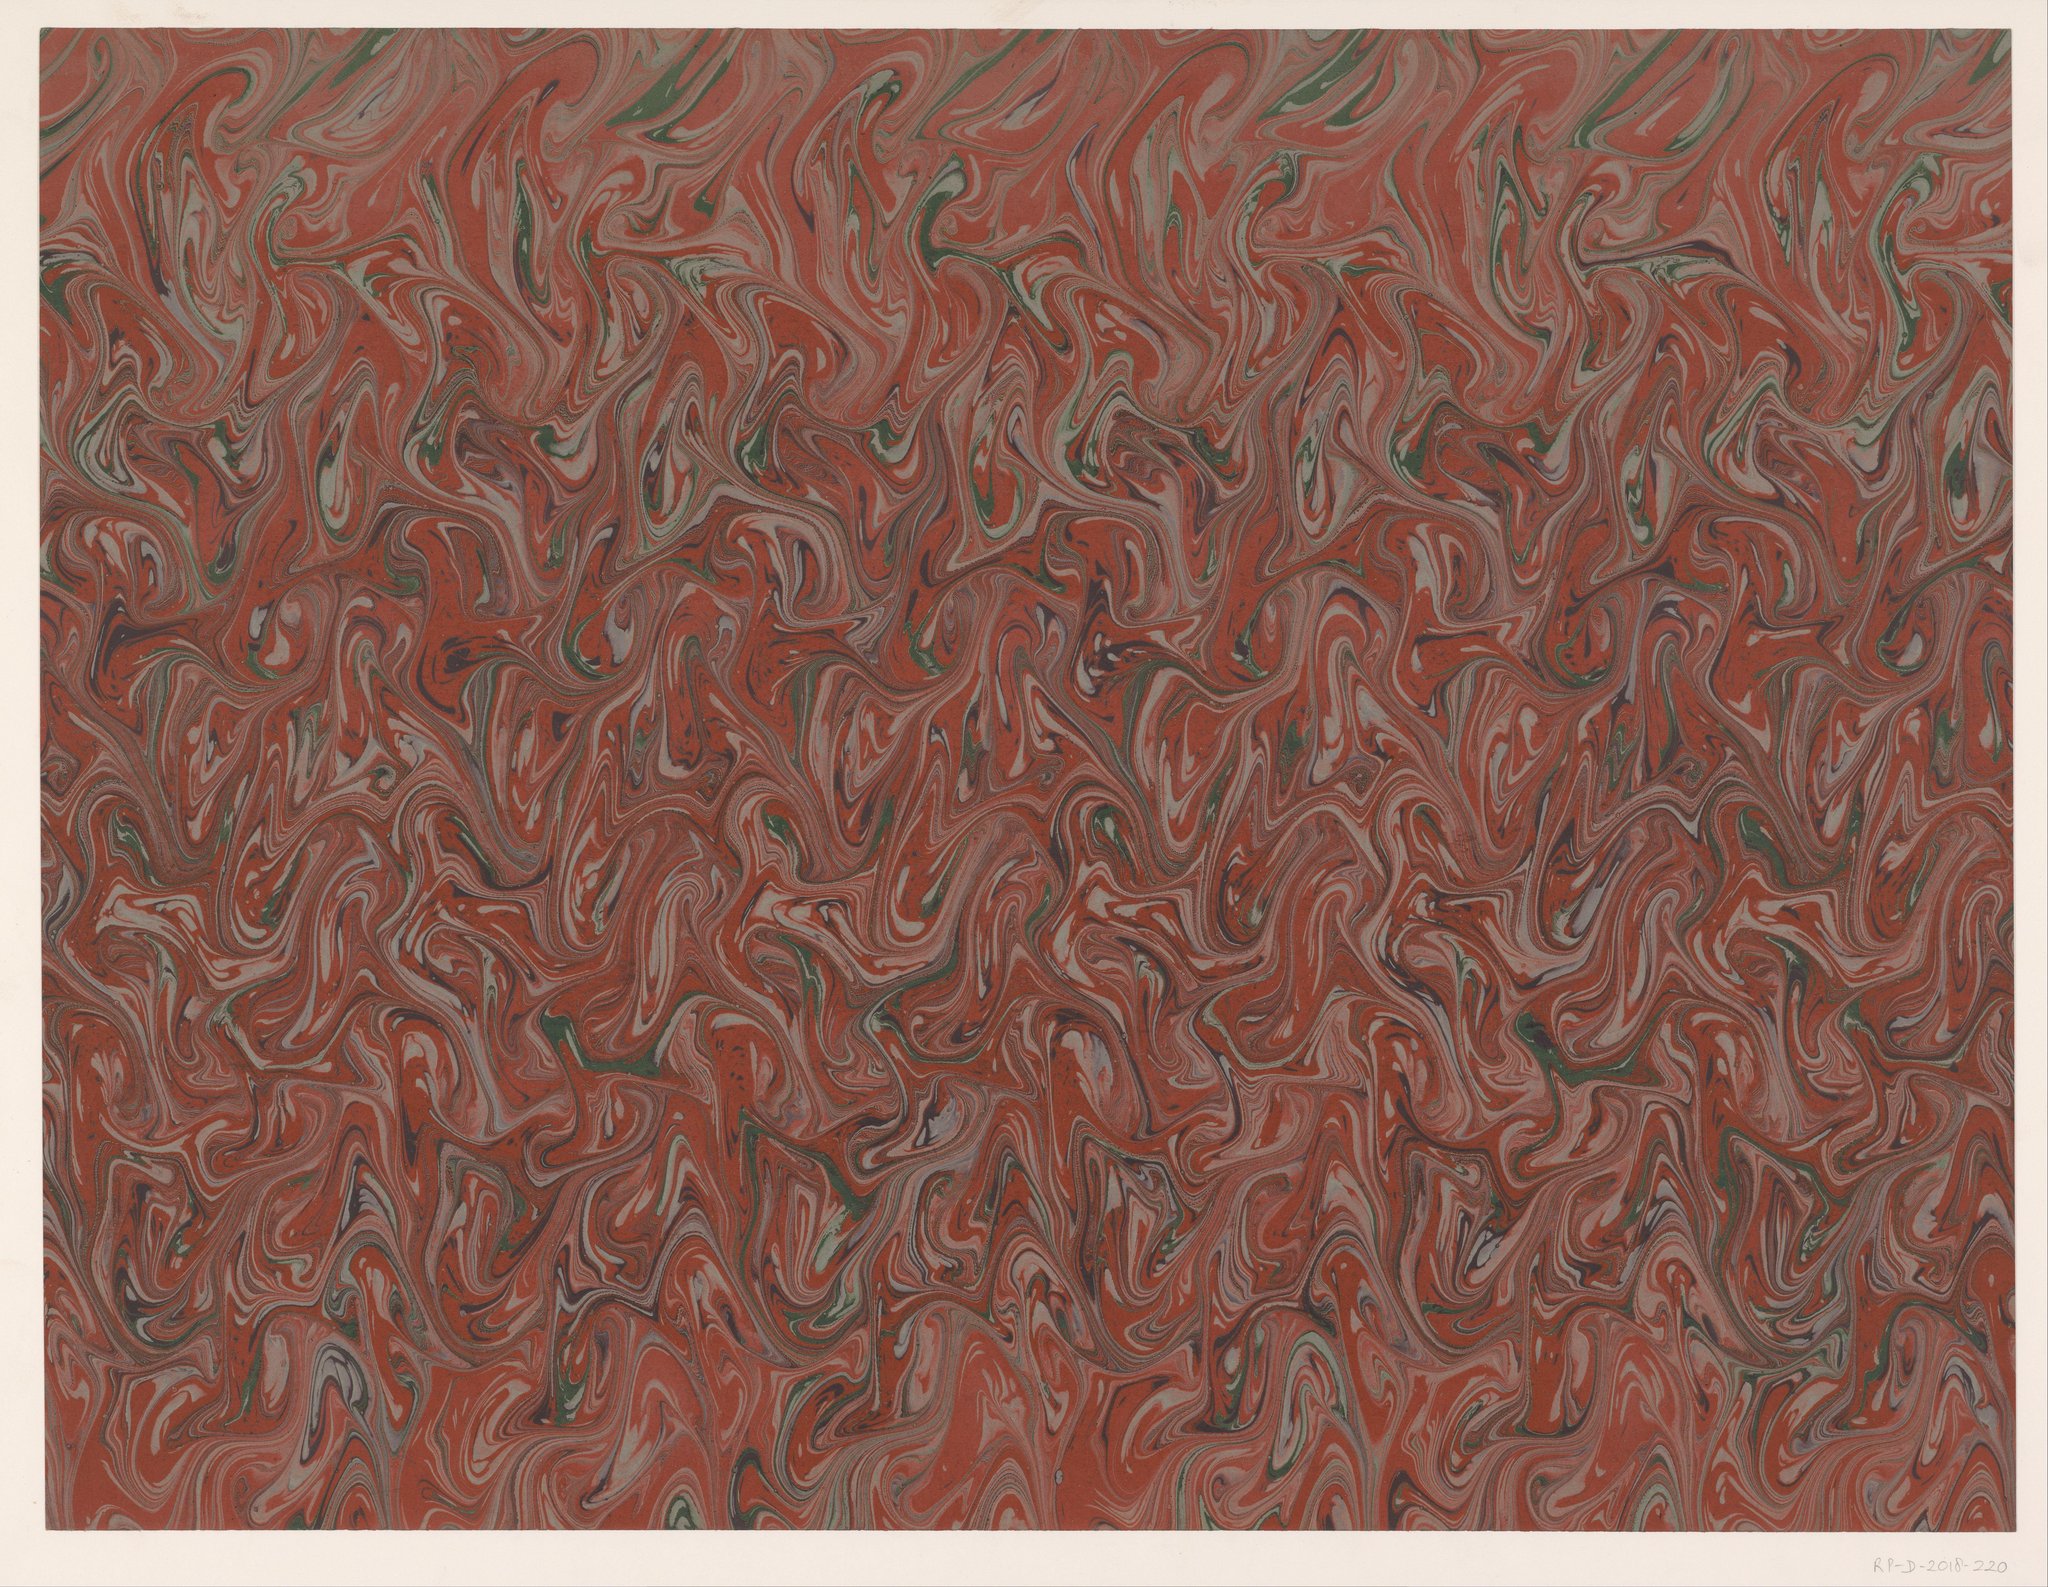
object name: marbled paper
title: Fantasiemarmer in verschillende tinten rood, grijs, groen en blauw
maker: Anonymous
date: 1900-2000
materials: paint, paper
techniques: marbled paper